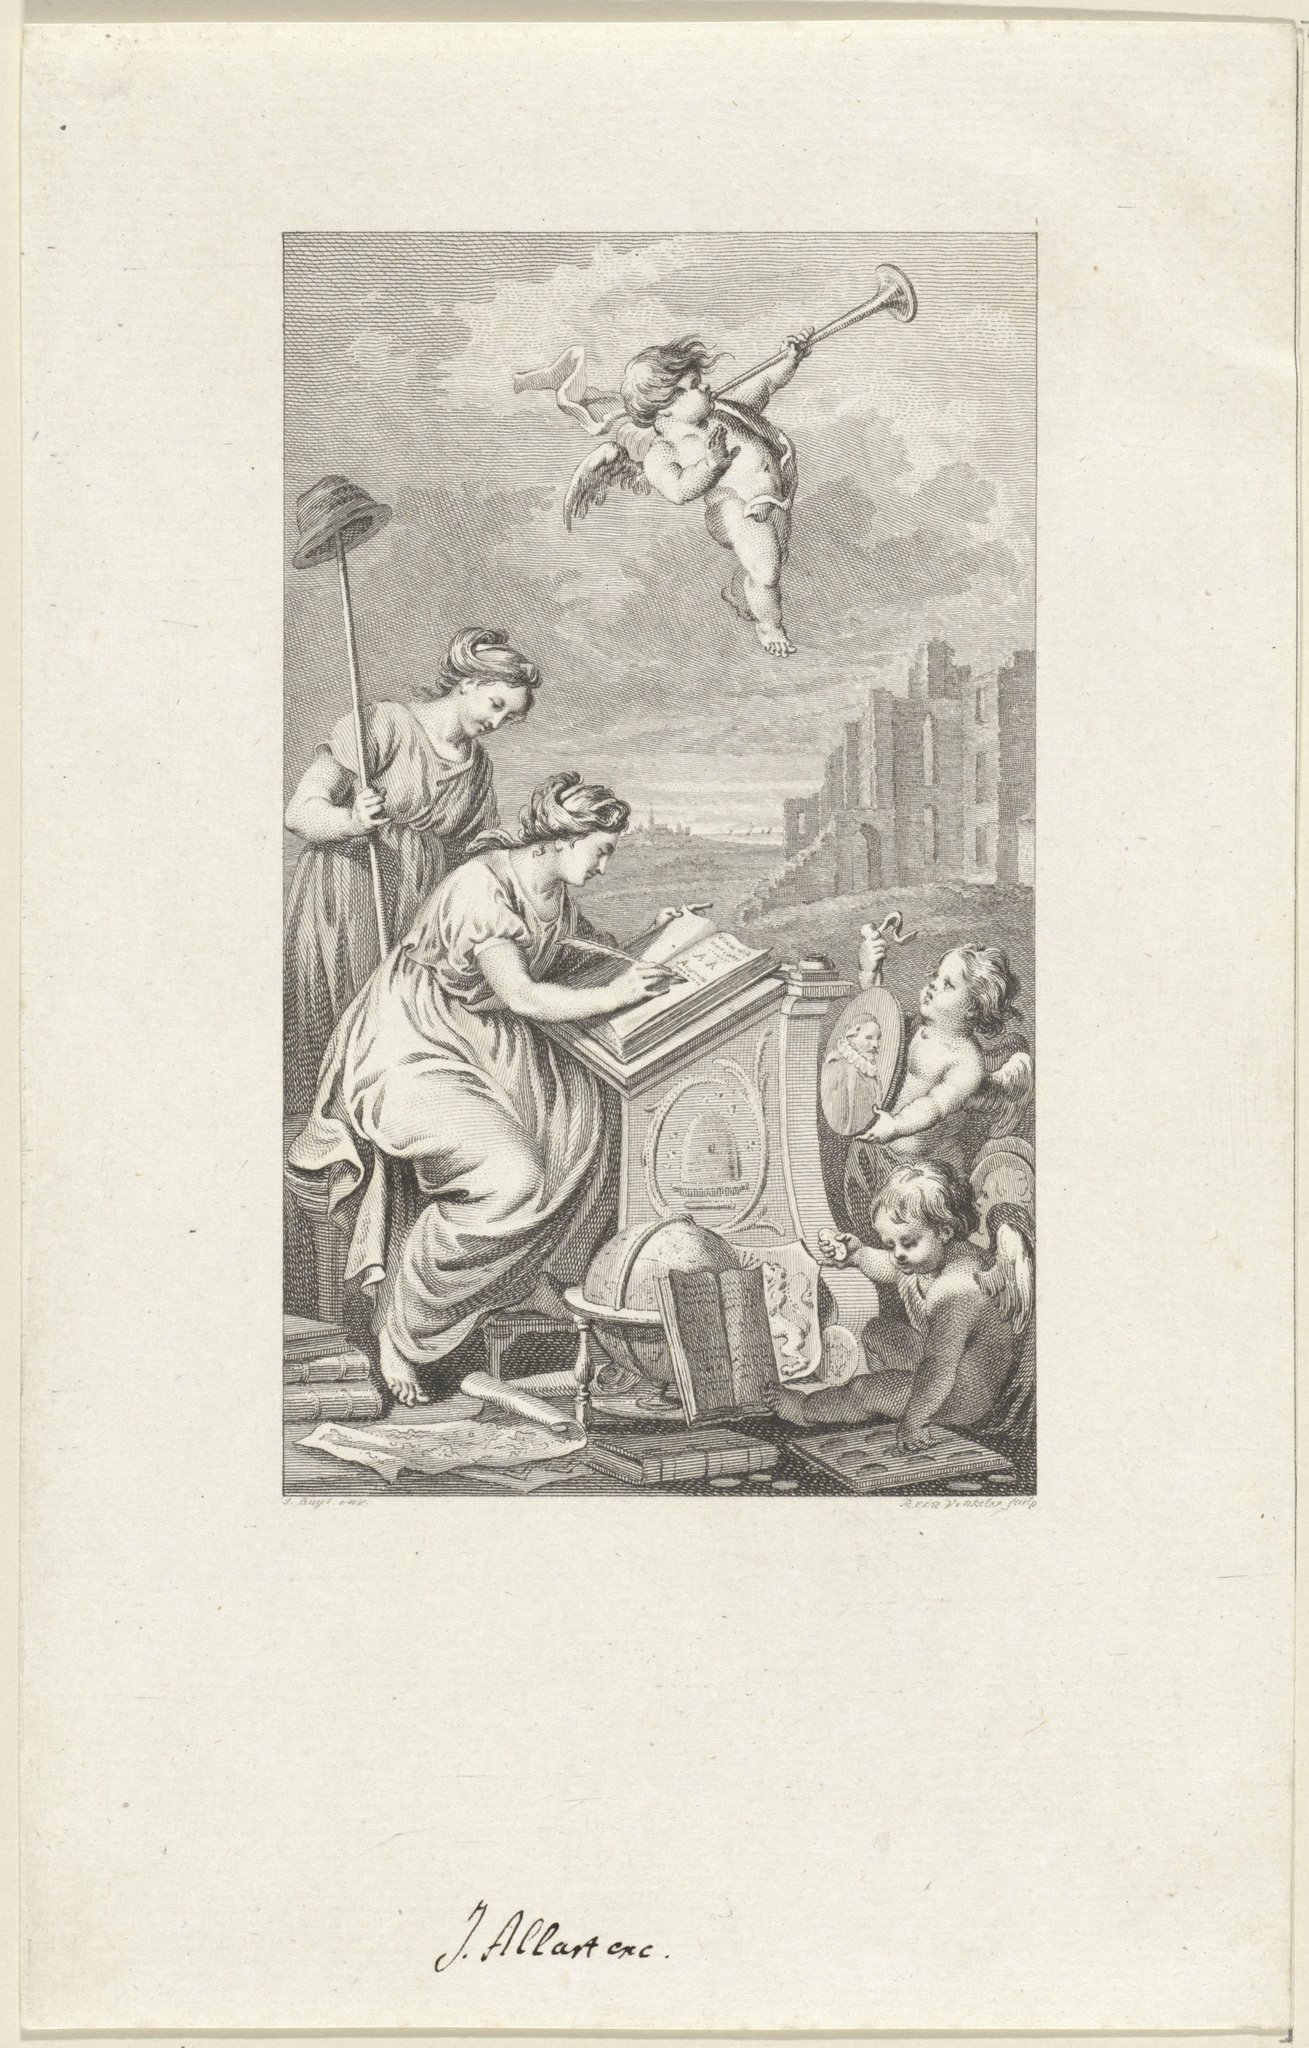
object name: print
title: Geschiedenis schrijft de historie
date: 1785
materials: paper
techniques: engraving, etching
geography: amsterdam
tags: 'historia'; 'historia' (ripa), freedom, liberty; 'libertà' (ripa), cupids: 'amores', 'amoretti', 'putti'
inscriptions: collector's mark: Lugt 240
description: Allegorische voorstelling waarin de personificatie van Geschiedenis zittend in een boek schrijft, achter haar de Vrijheid, in de lucht een putti met een bazuin. Voor de schrijftafel nog twee putti.